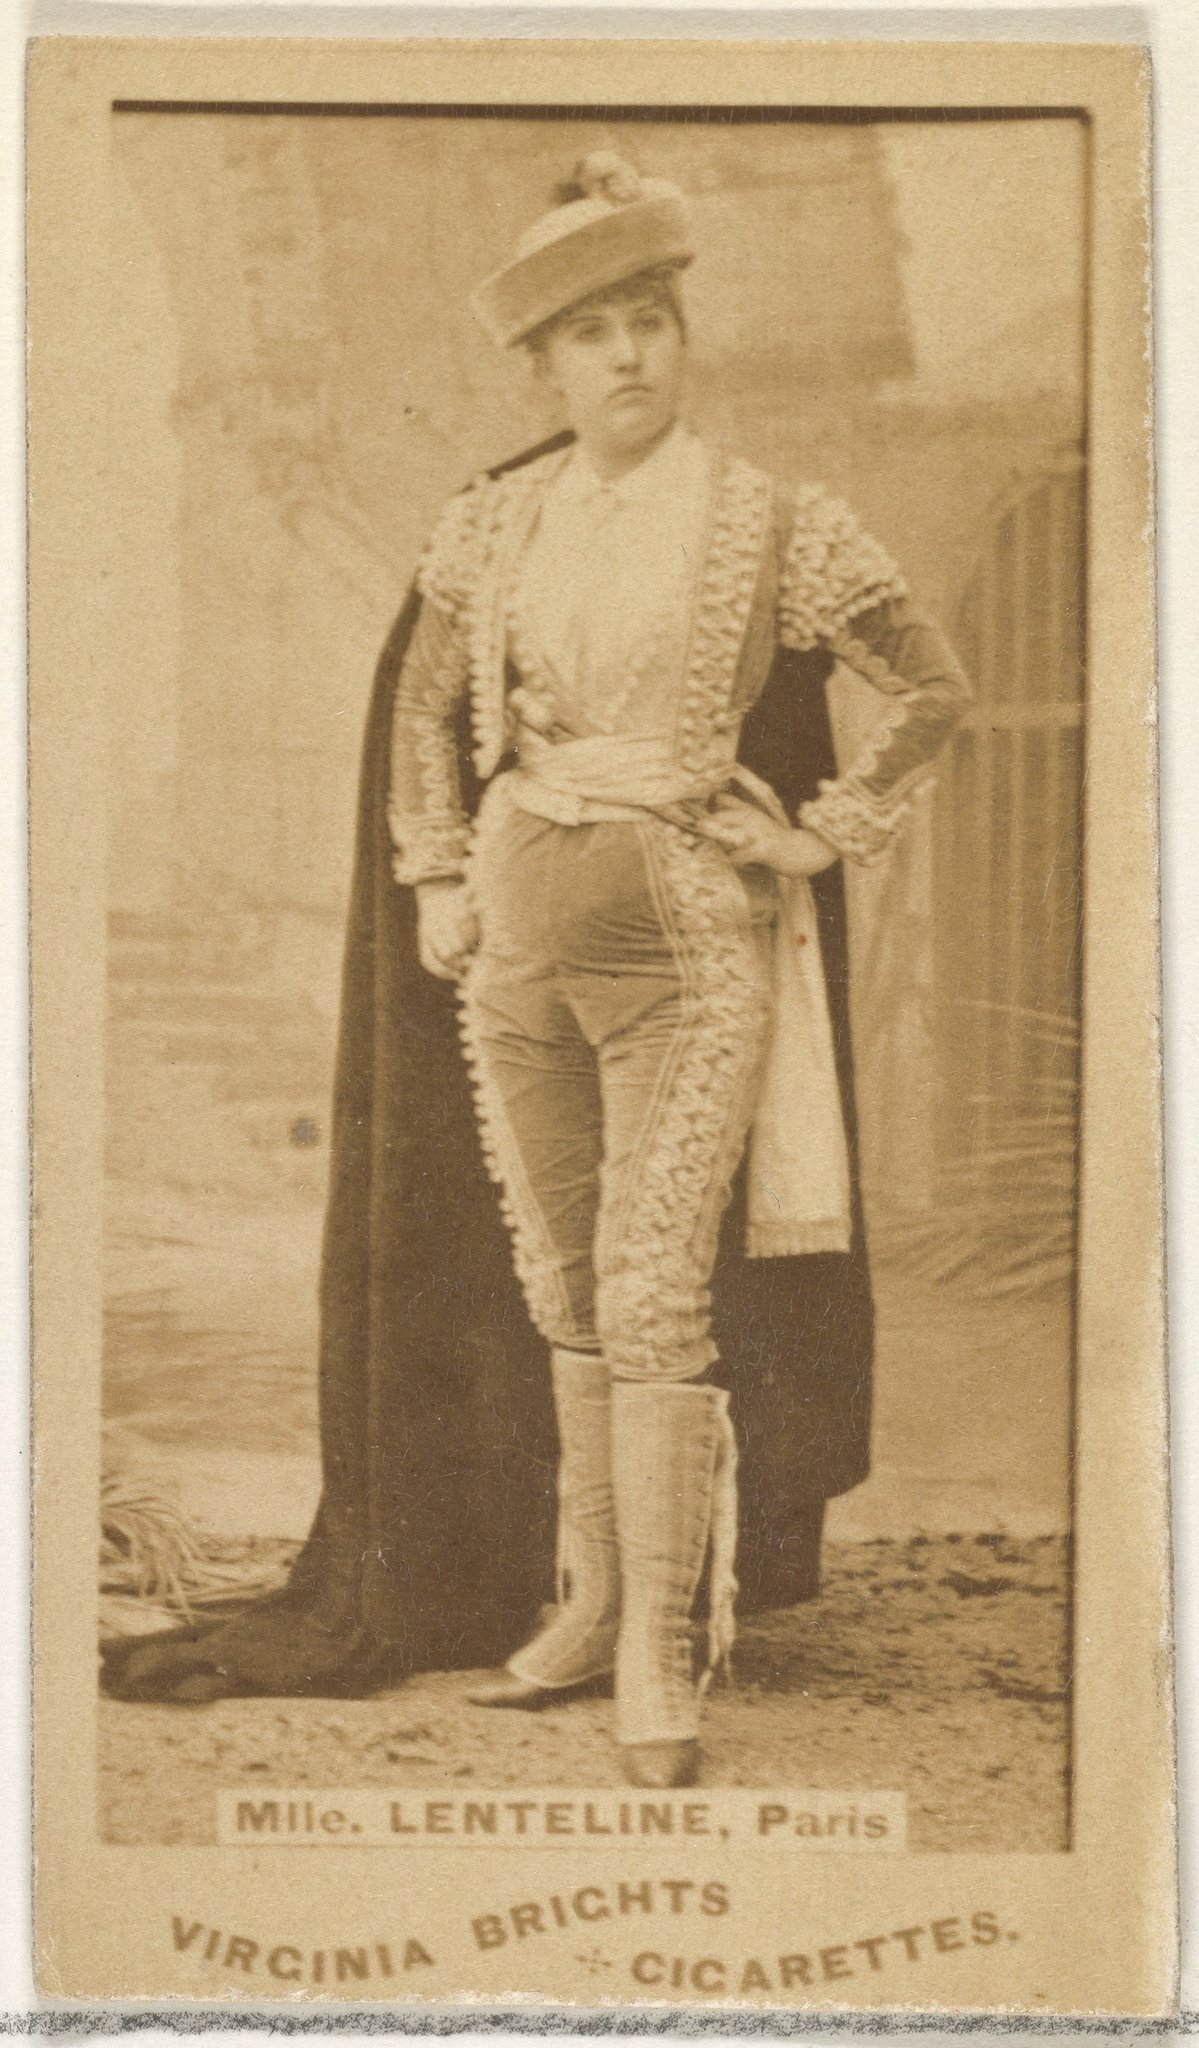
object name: photograph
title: Mlle. Lenteline, Paris, from the Actors and Actresses series (N45, Type 1) for Virginia Brights Cigarettes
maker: allen & ginter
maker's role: publisher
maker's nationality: american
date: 1888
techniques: albumen silver print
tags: portraits,women,actresses